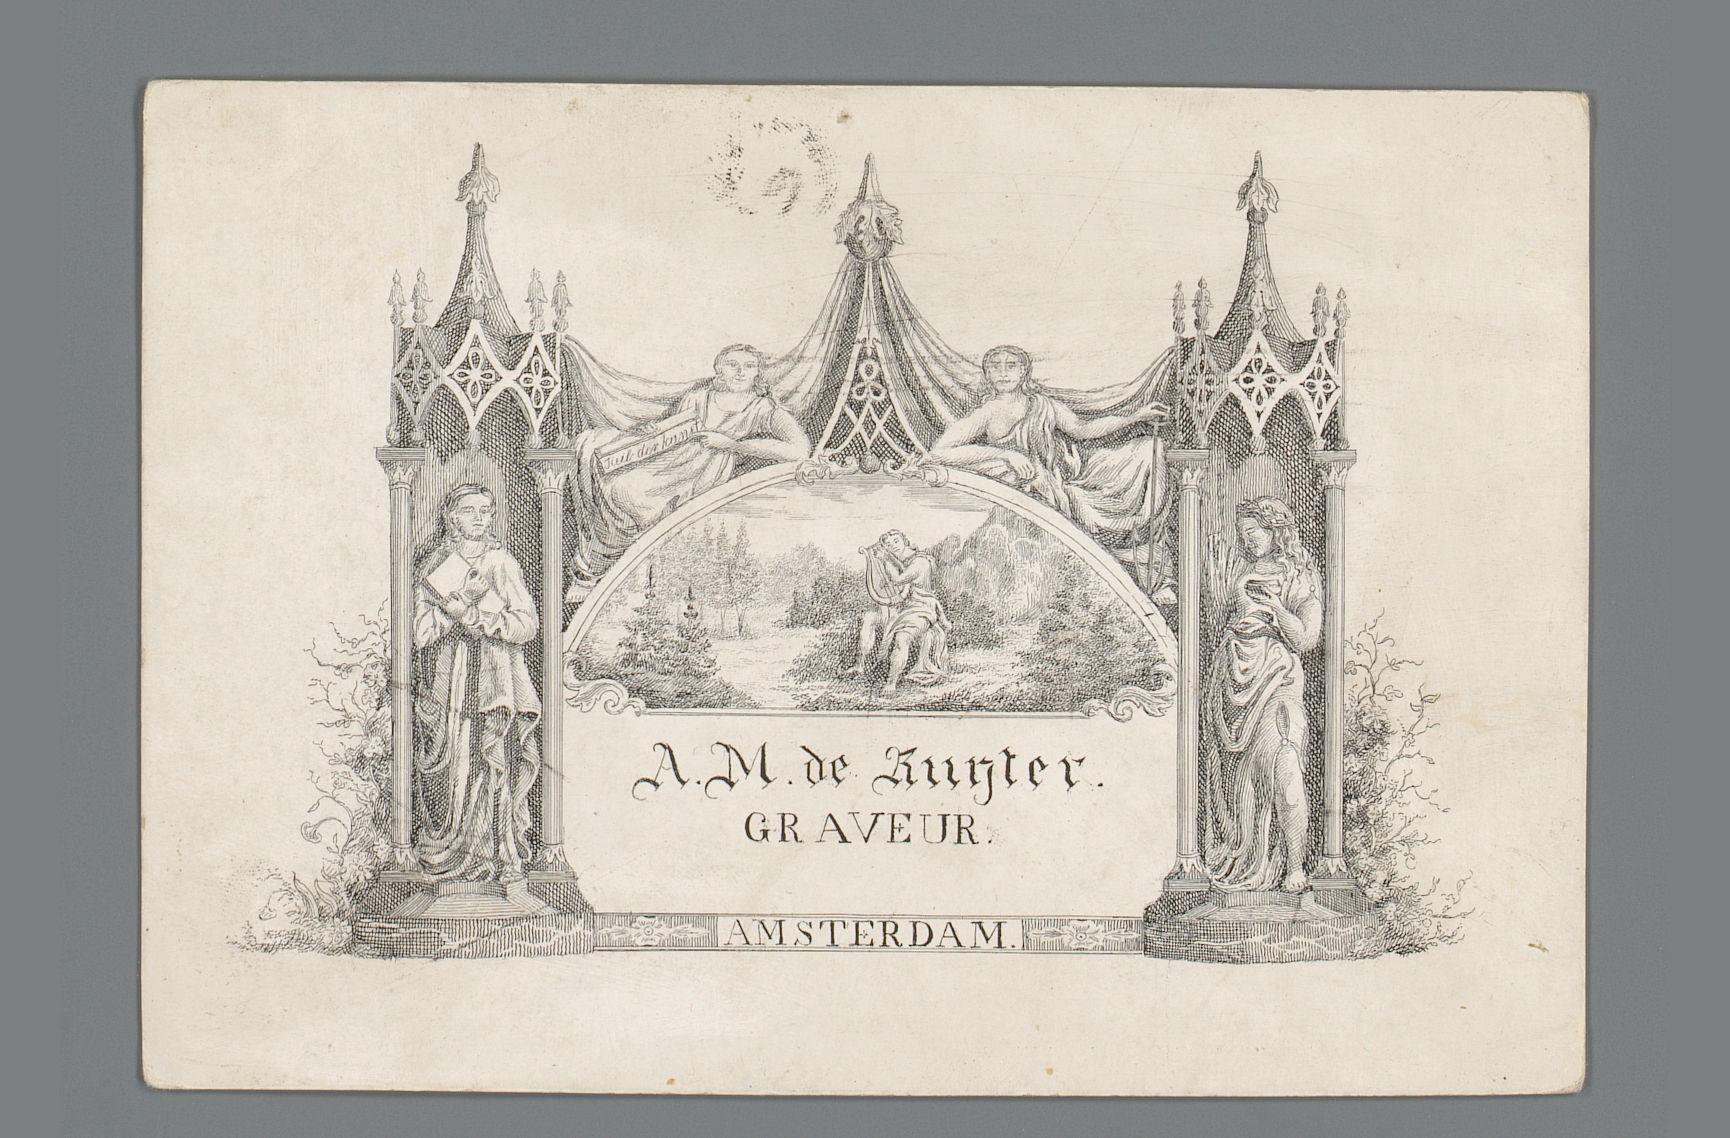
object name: print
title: Visitekaart van van Aadrianus Martinus de Ruyter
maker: adrianus martinus de ruyter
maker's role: print maker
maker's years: 1822-1905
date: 1832-1905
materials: paper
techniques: engraving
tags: amsterdam, adrianus martinus de ruyter, landscapes in the temperate zone, visiting-card, calling-card, harp - cc - out of doors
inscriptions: annotation: ‘Inrigting voor Staal-, steen-, en glyptographische gravuren. 2de Hoogstraat br. No. 25’, collector's mark: Lugt 2166, collector's mark: Lugt 2760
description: Een harpspelende figuur in een landschap, met daaromheen architectonische elementen met figuren erin verwerkt. Daaronder de tekst: 'A.M. de Ruyter. Graveur. Amsterdam'.